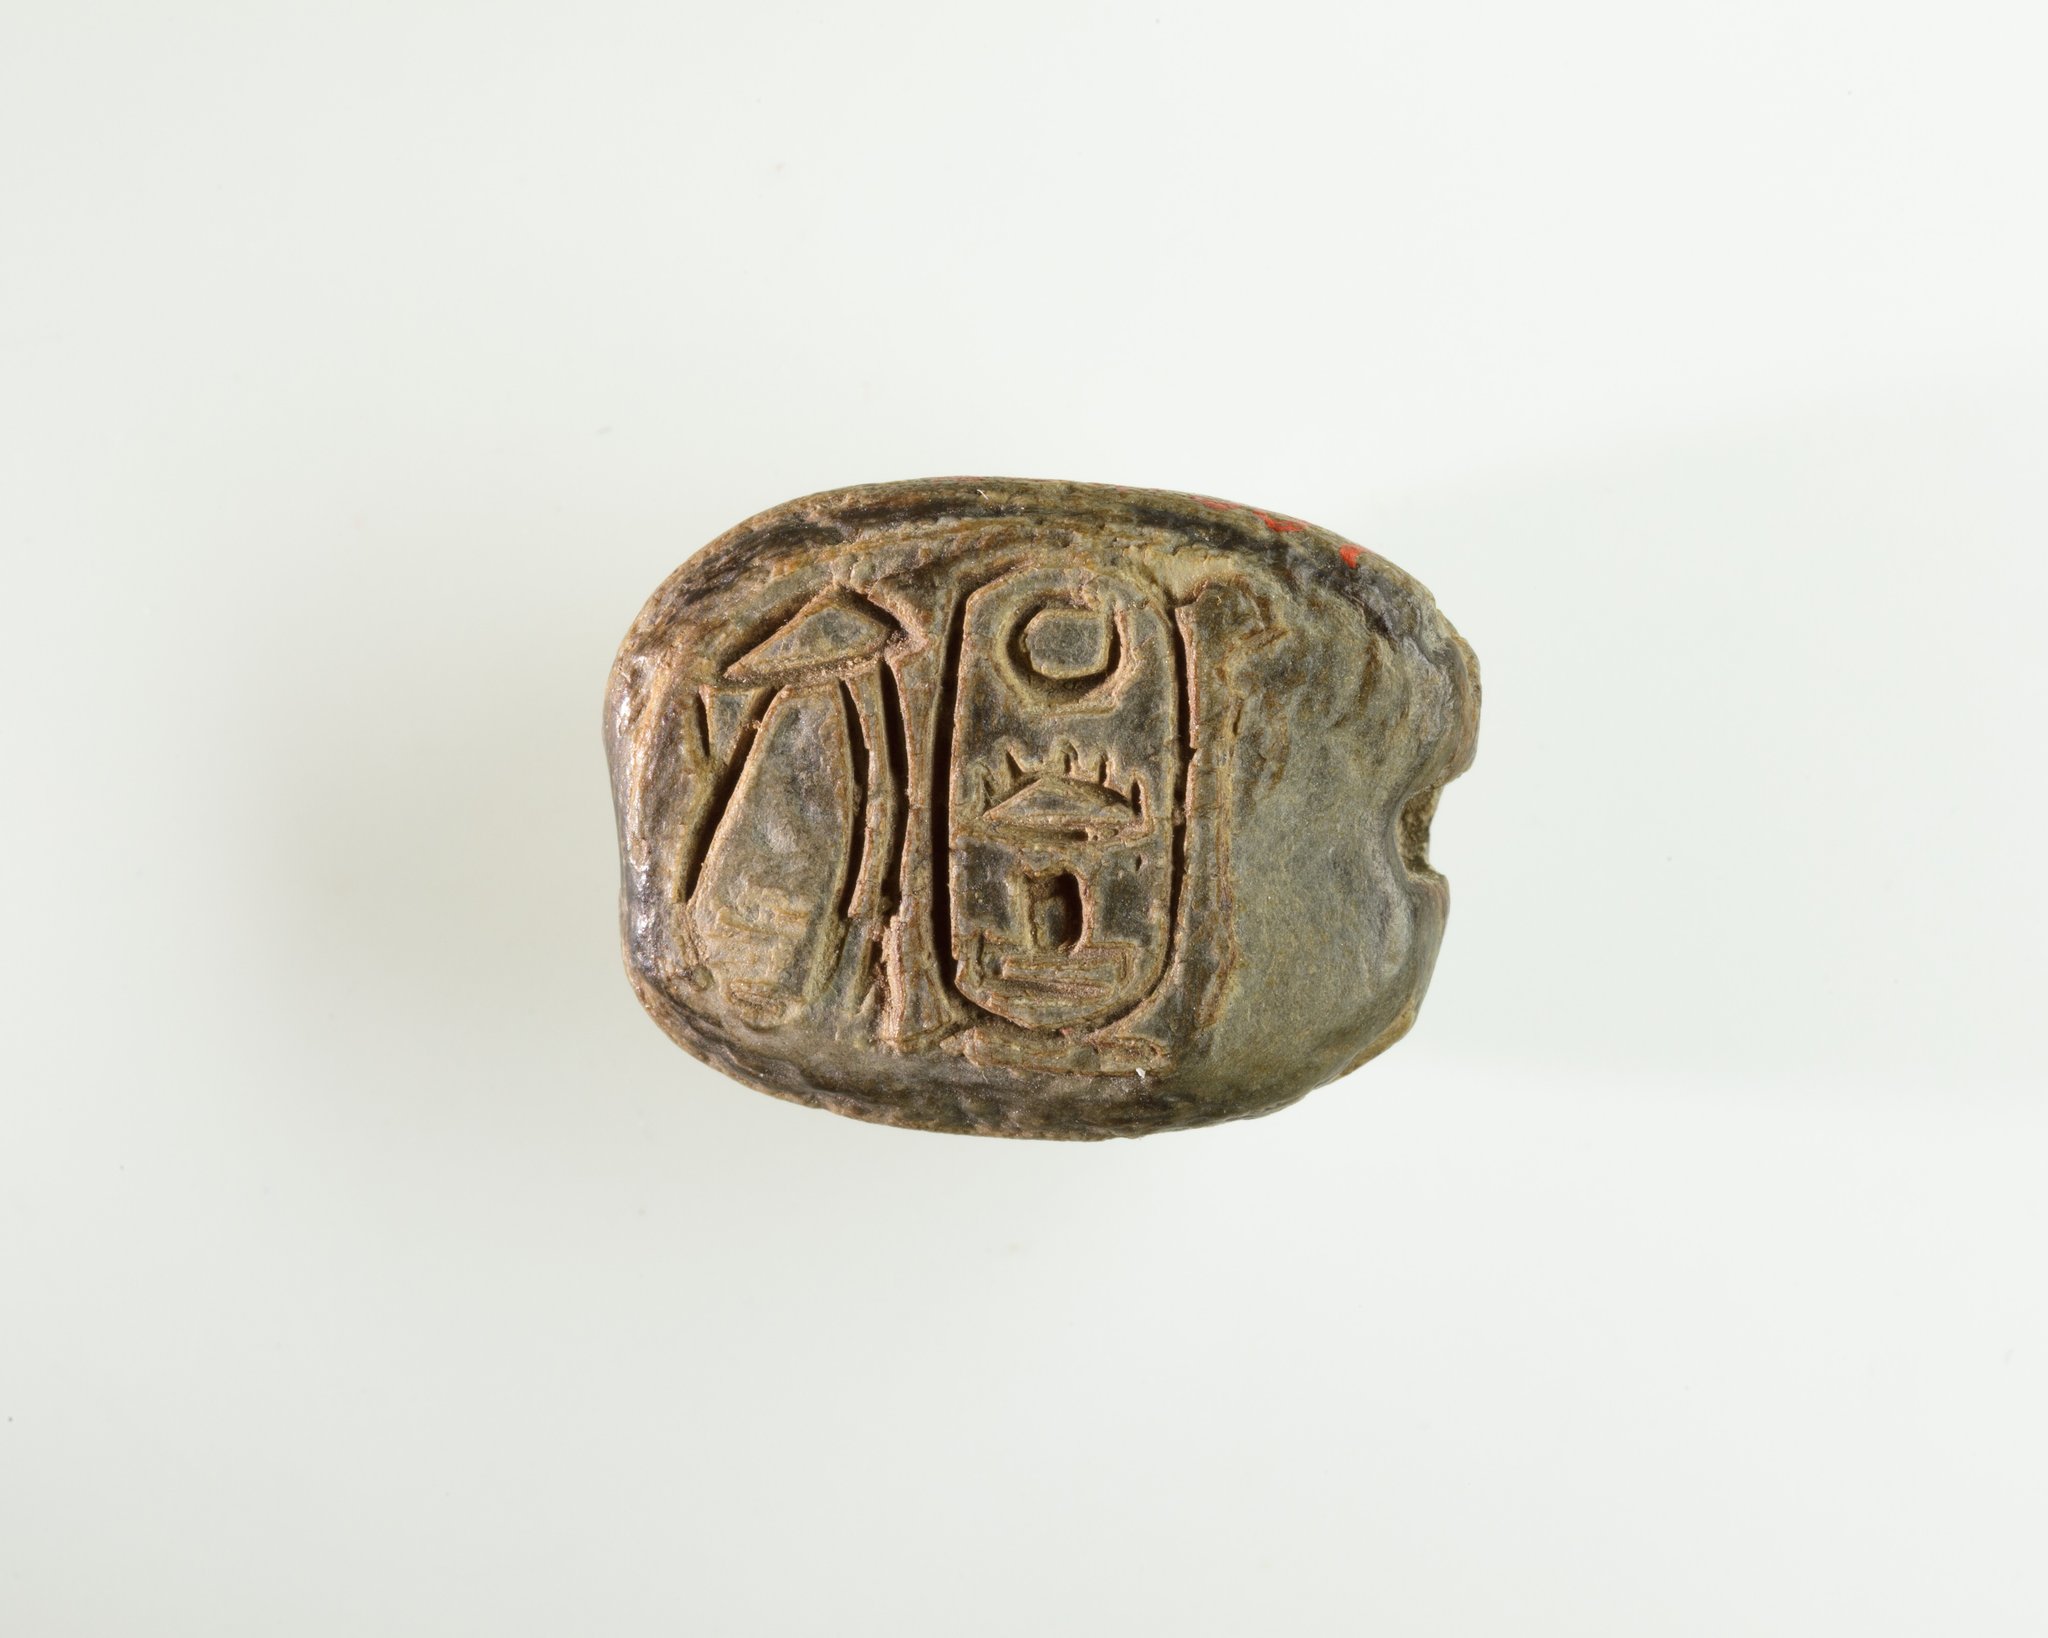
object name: scarab, papyrus, cartouche, re, sebekhotep vi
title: Scarab Inscribed for Sebekhotep VI (?)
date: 1760-1640 BCE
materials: stone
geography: egypt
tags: cartouches,scarabs